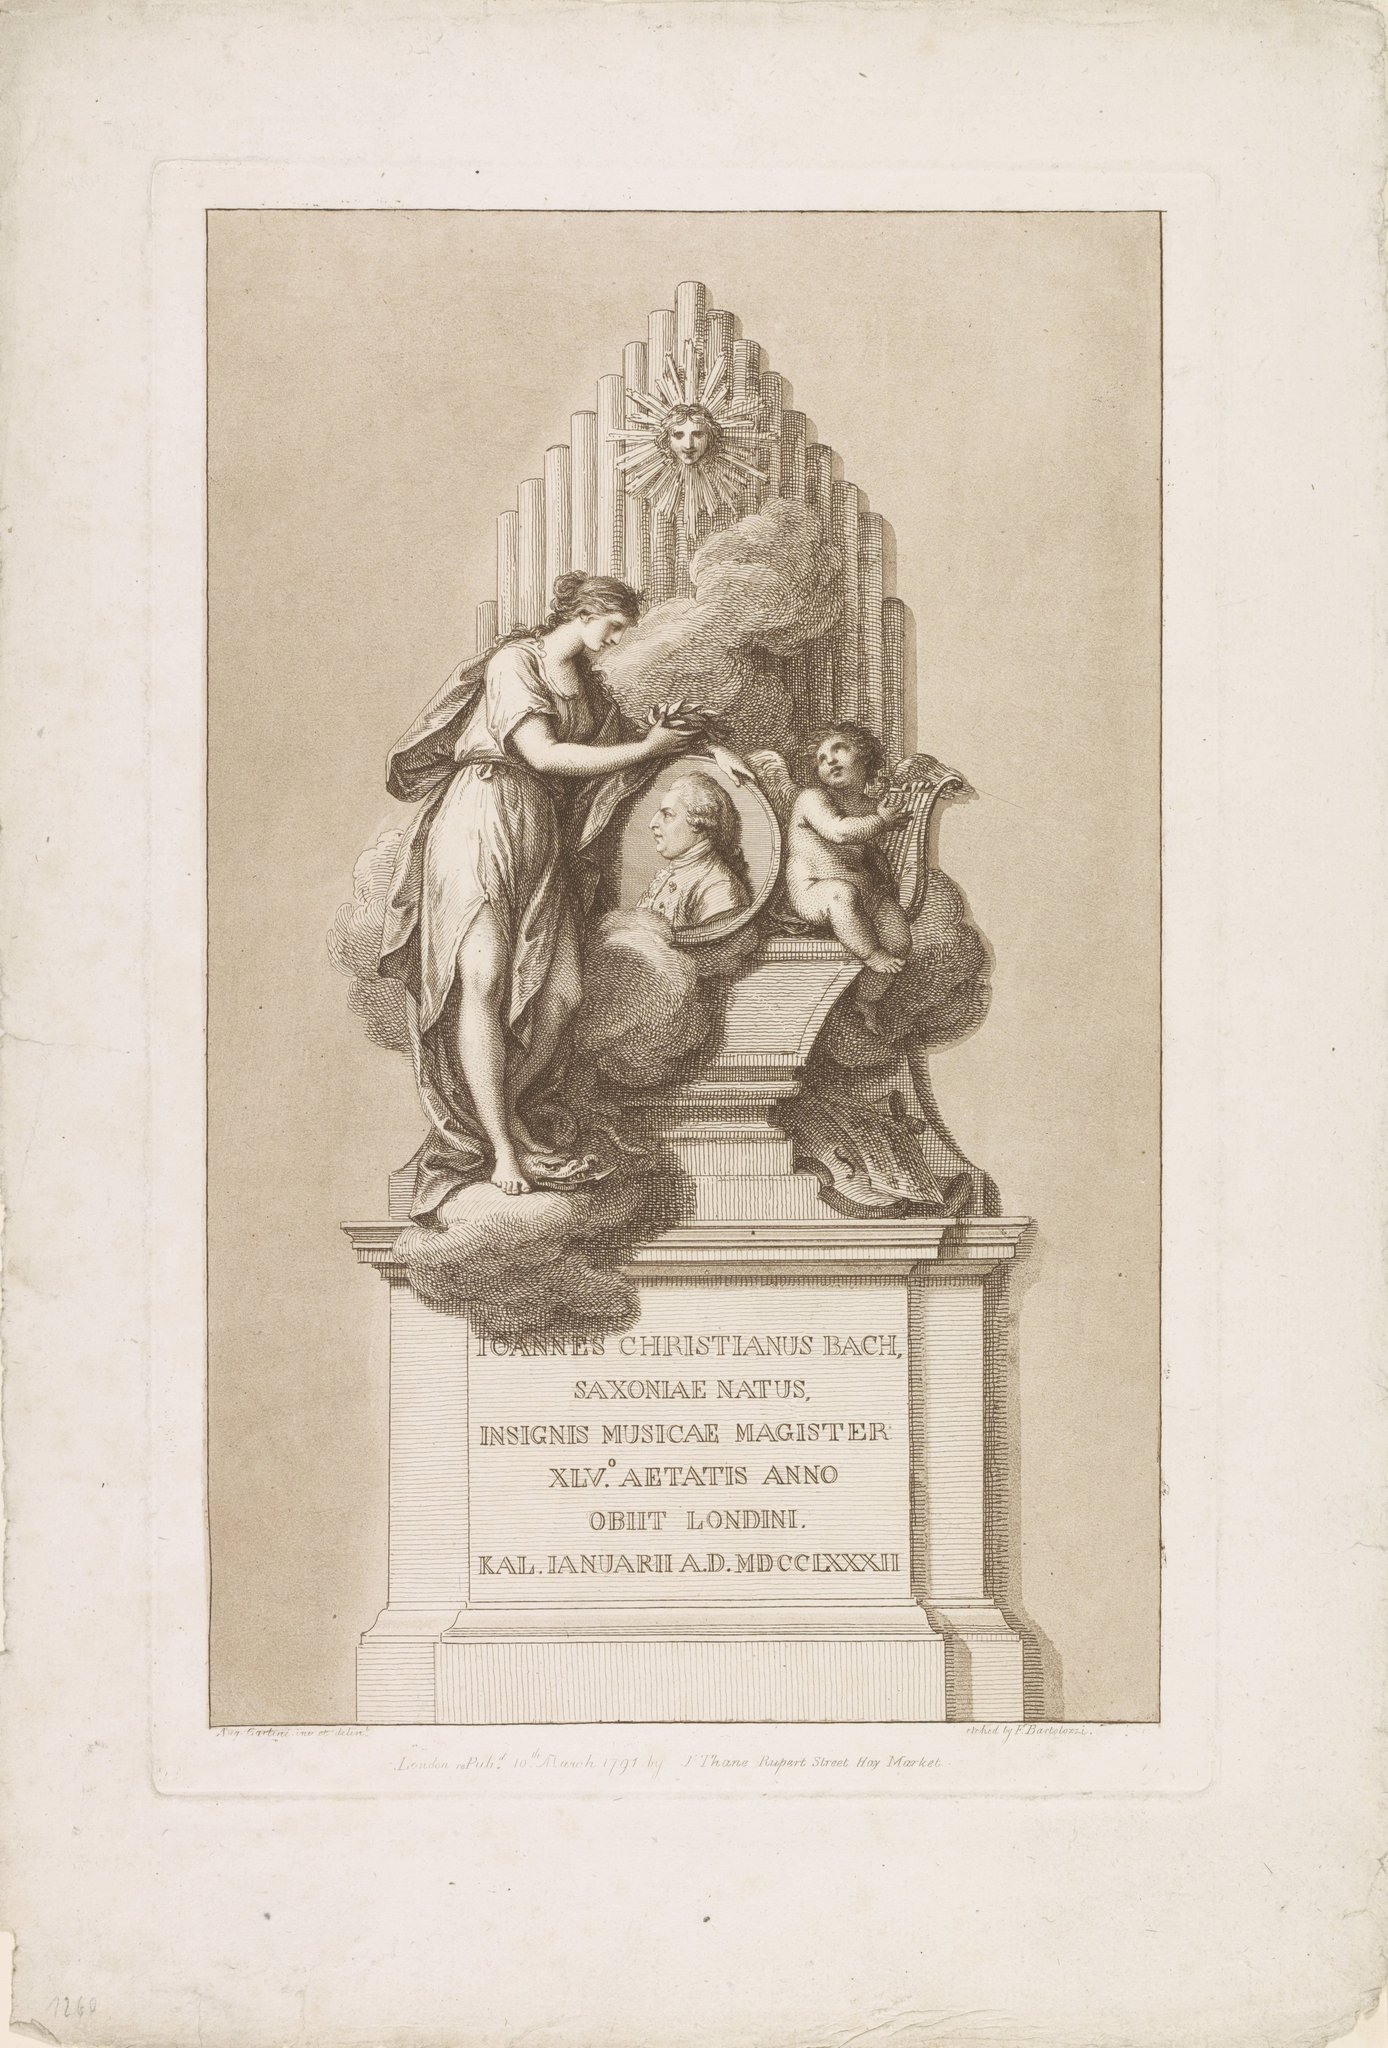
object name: print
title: Epitaaf met portret van Johann Christian Bach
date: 1791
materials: paper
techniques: etching, intaglio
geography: london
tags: historical persons, monument, statue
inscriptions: collector's mark: Lugt 2760, collector's mark: Lugt 2228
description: Epitaaf met een allegorie op de muziek en een medaillon met het portret van Johann Christian Bach.